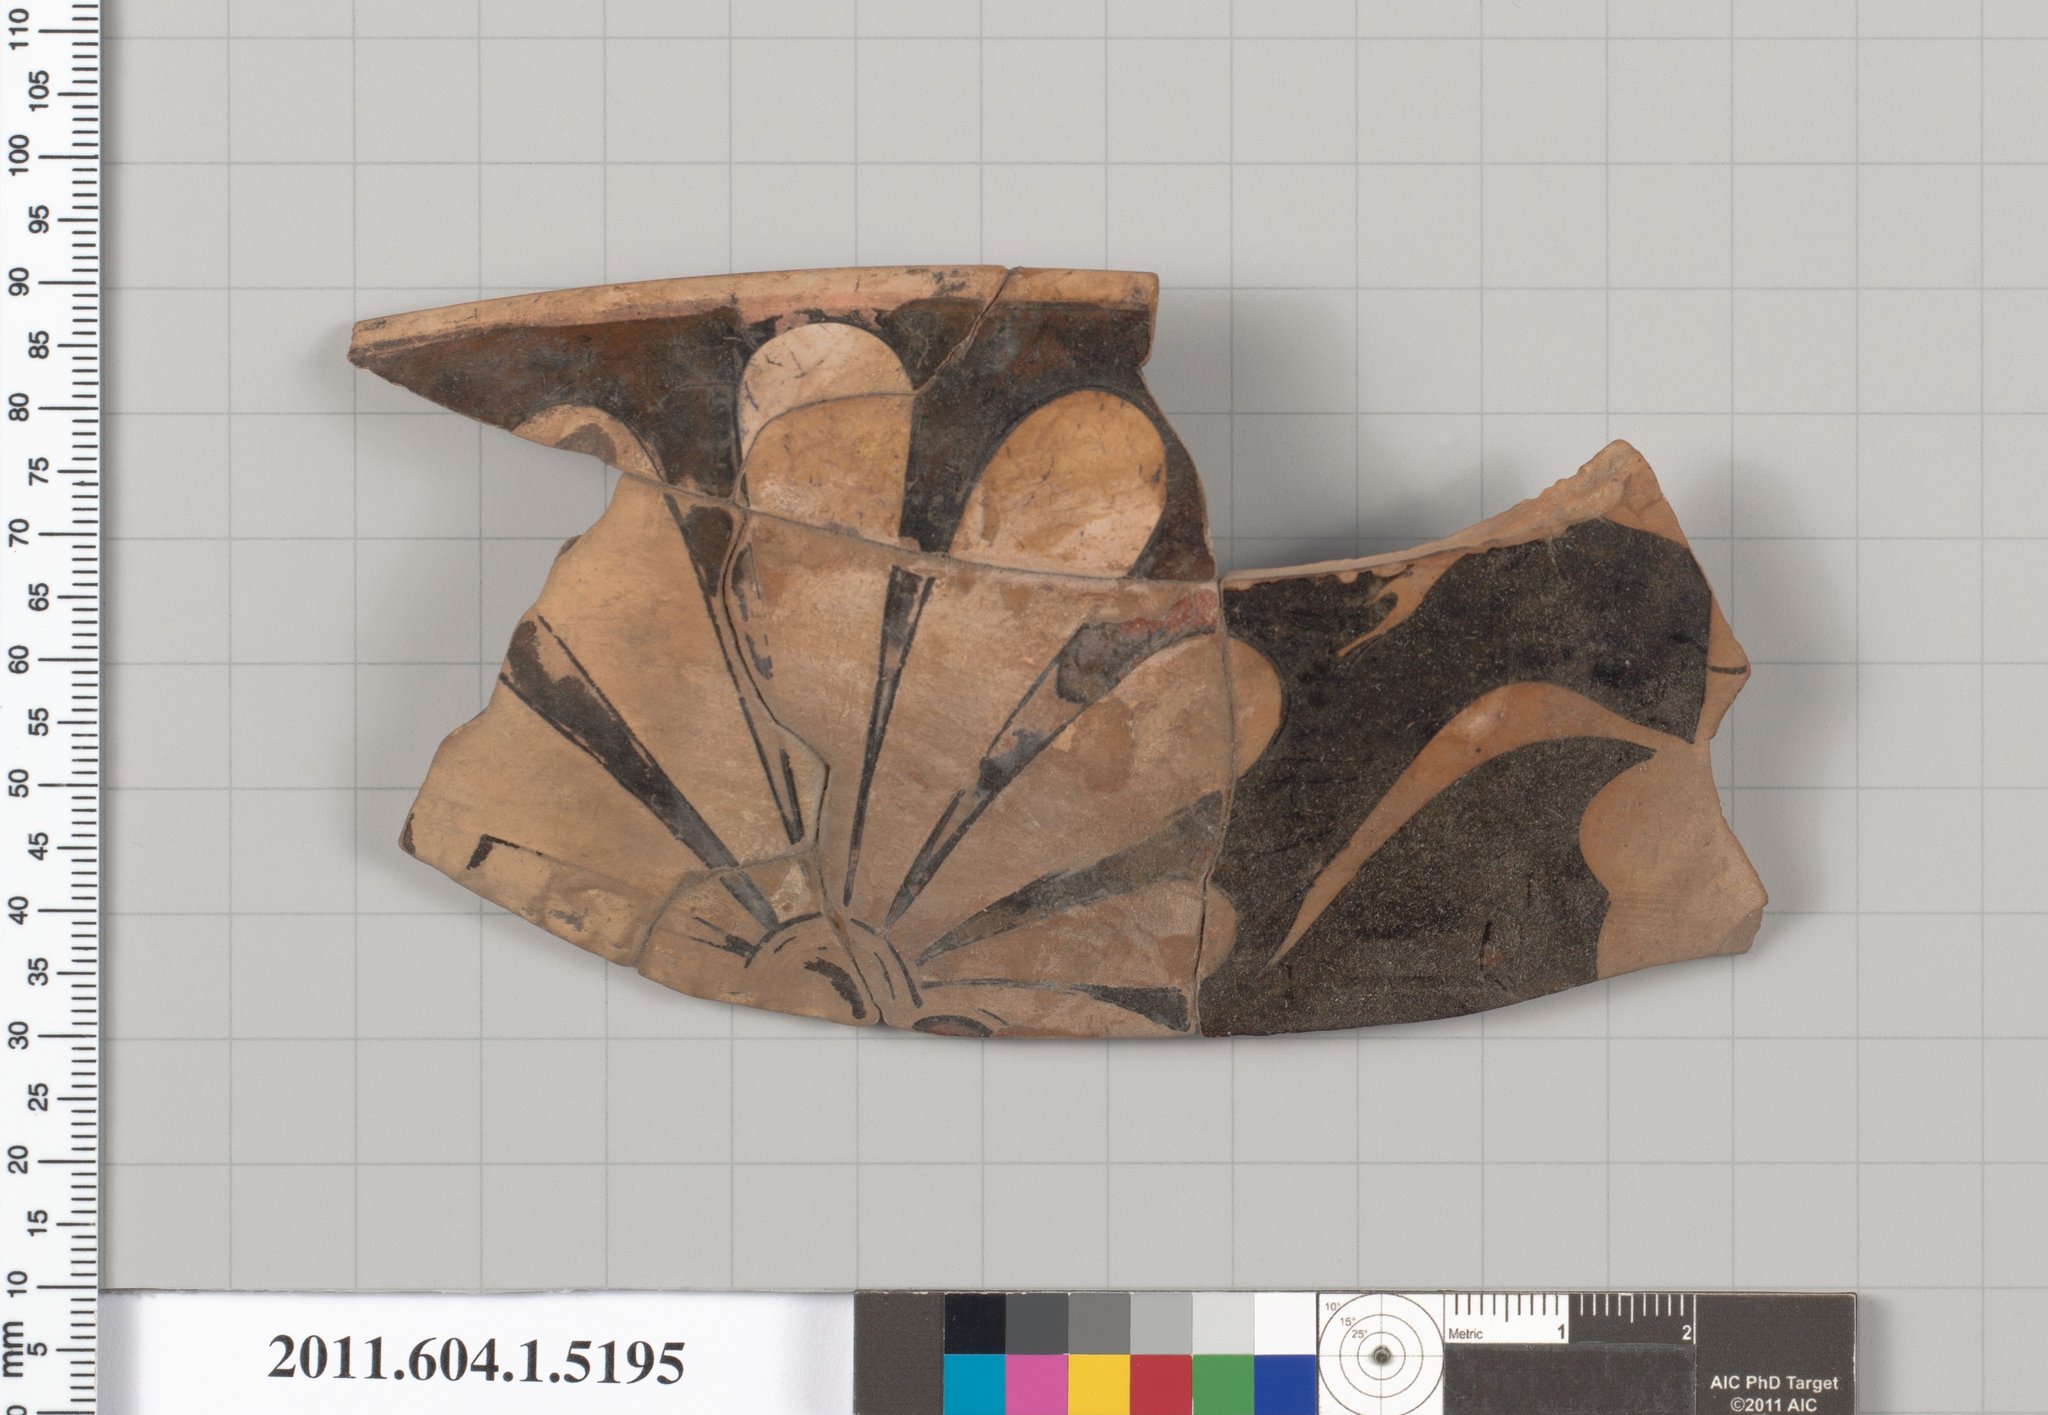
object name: kylix fragment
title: Terracotta fragment of a kylix (drinking cup)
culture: greek, attic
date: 520-510 BCE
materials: terracotta